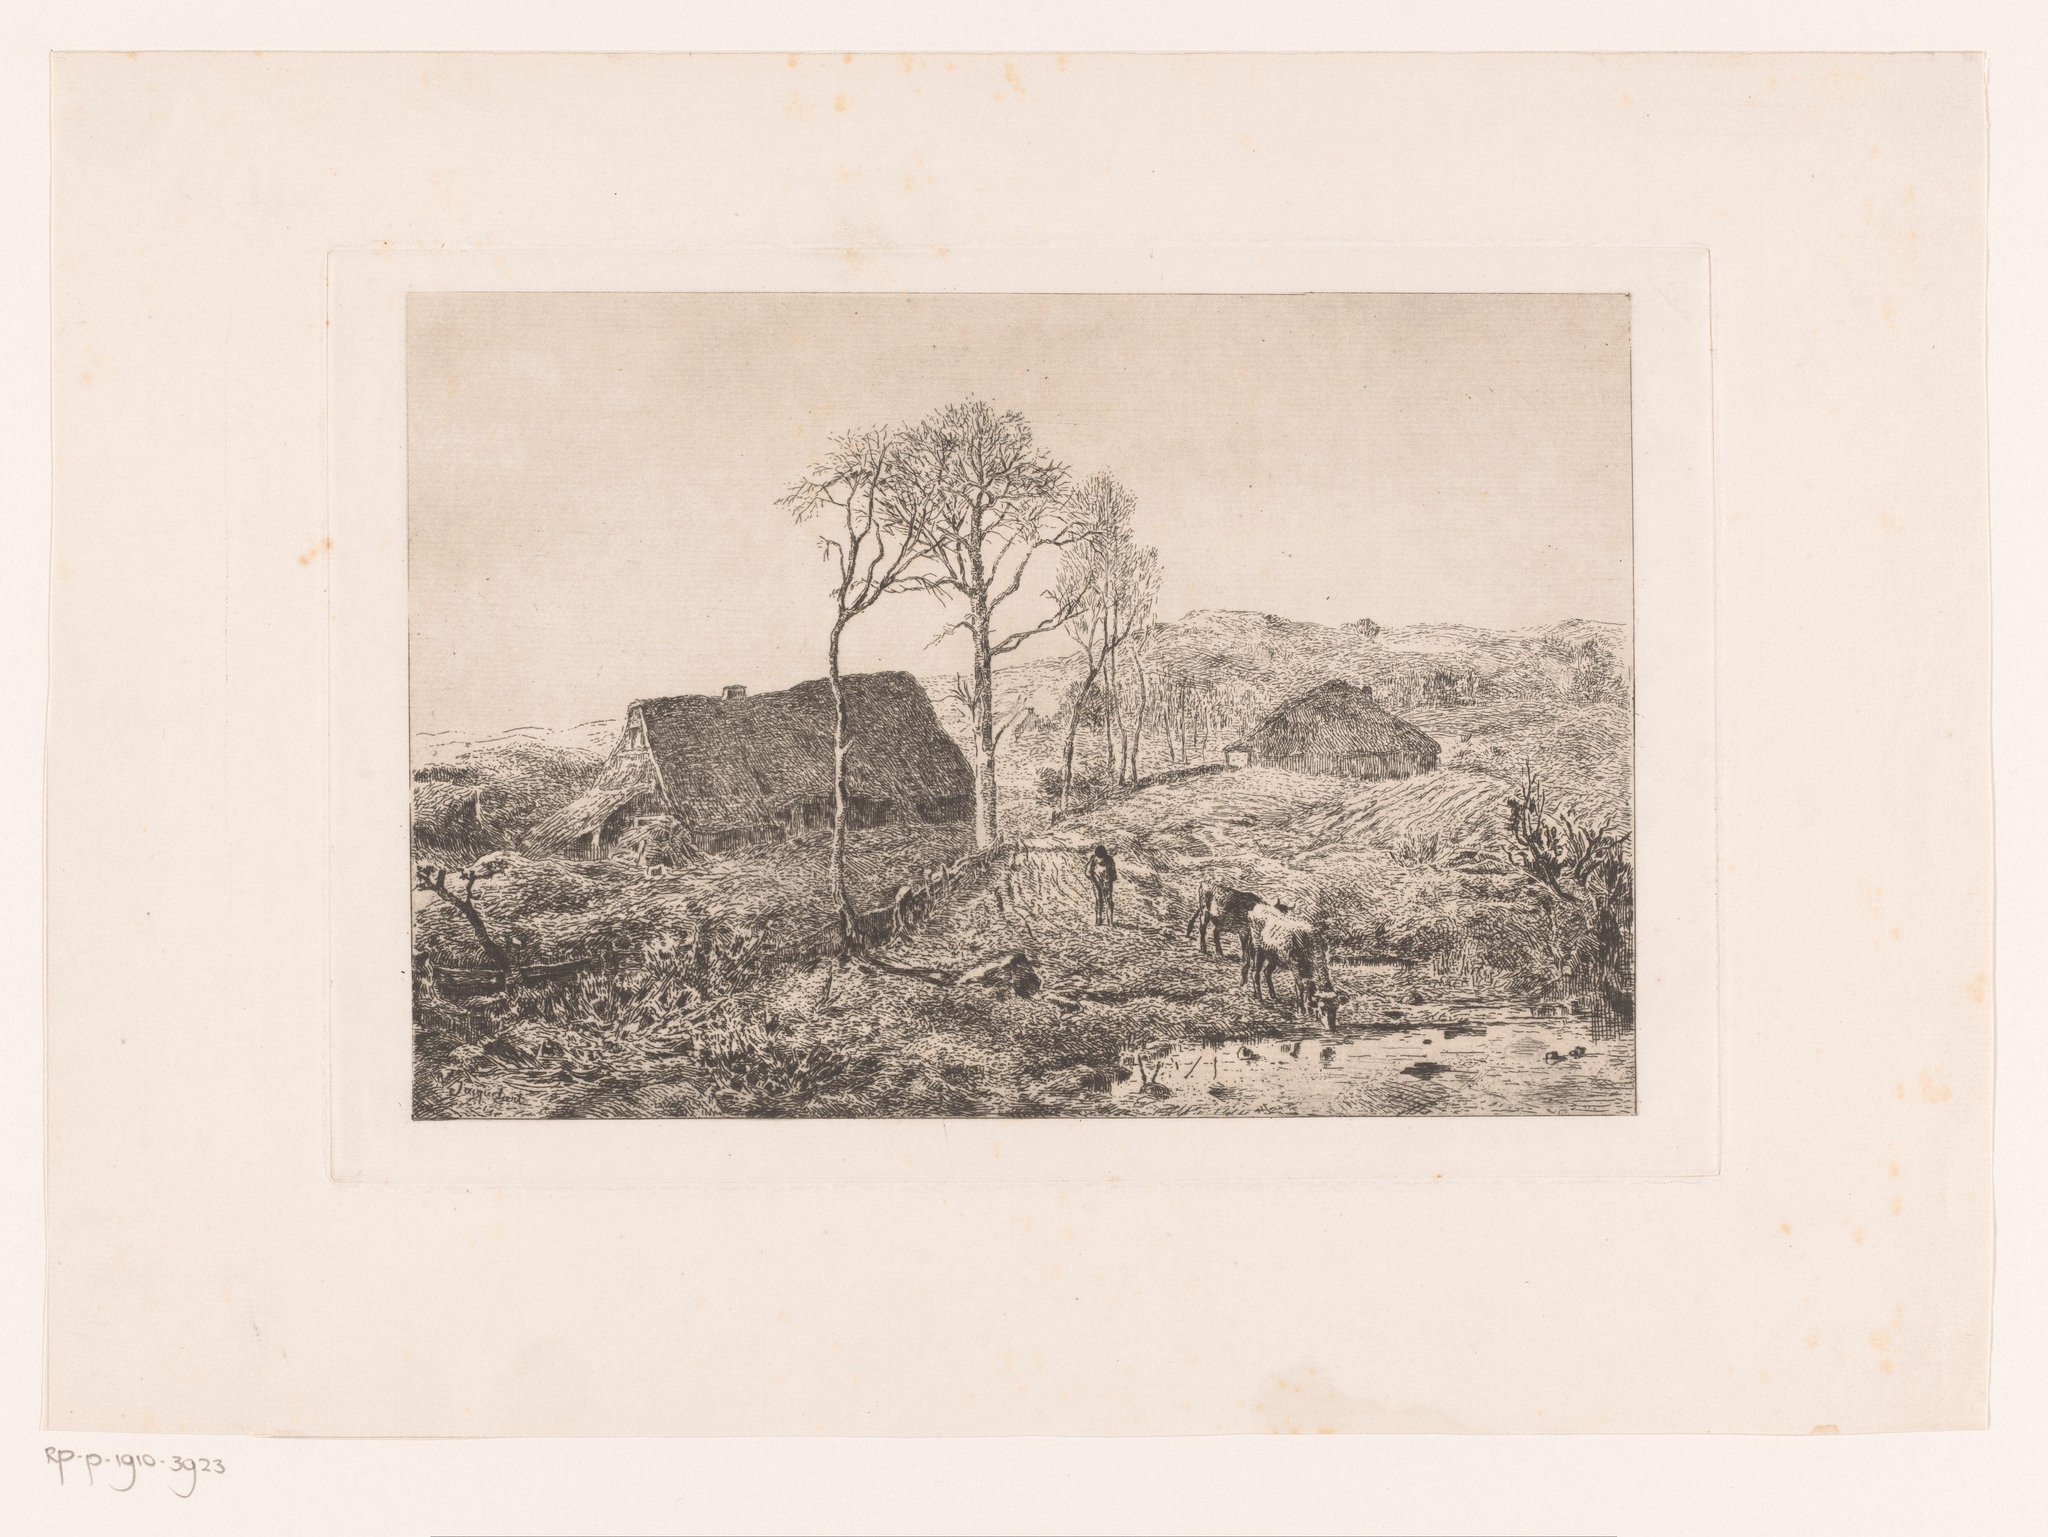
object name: print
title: Drinkende koe in een landschap met boerderijen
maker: lambert jacquelart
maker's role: print maker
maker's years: 1820-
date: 1830-1910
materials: paper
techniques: etching, intaglio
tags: cow, farm or solitary house in landscape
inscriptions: collector's mark: Lugt 2228